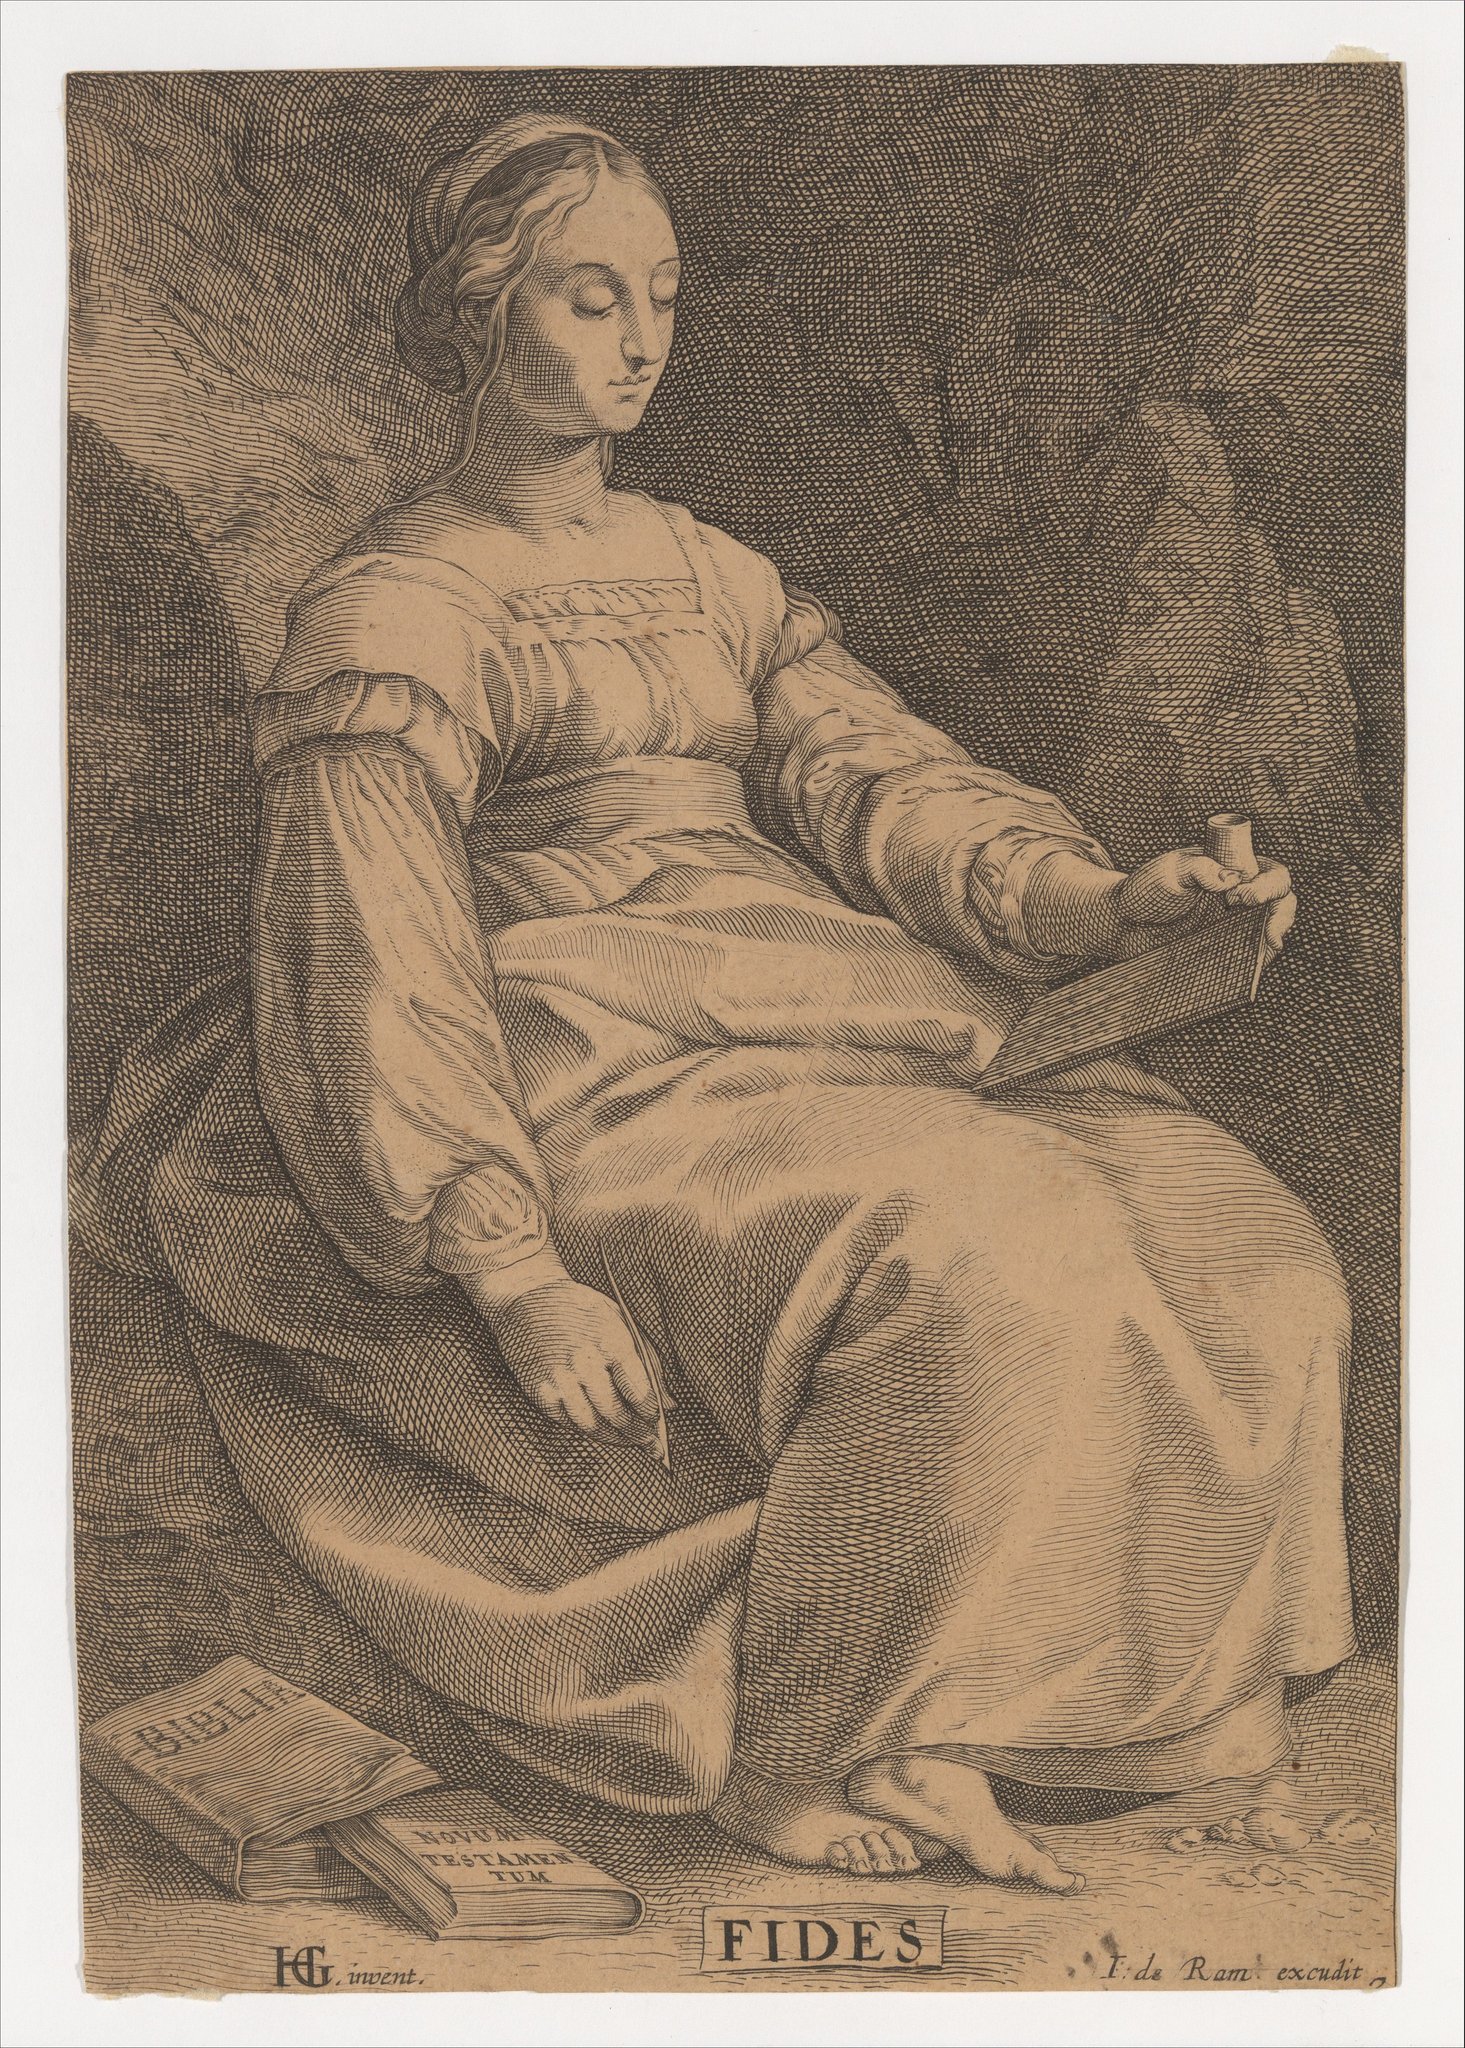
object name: print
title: Fides (copy)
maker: anonymous, dutch, 17th century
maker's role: artist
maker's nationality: dutch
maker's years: 1600-1700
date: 1667-1700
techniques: engraving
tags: women